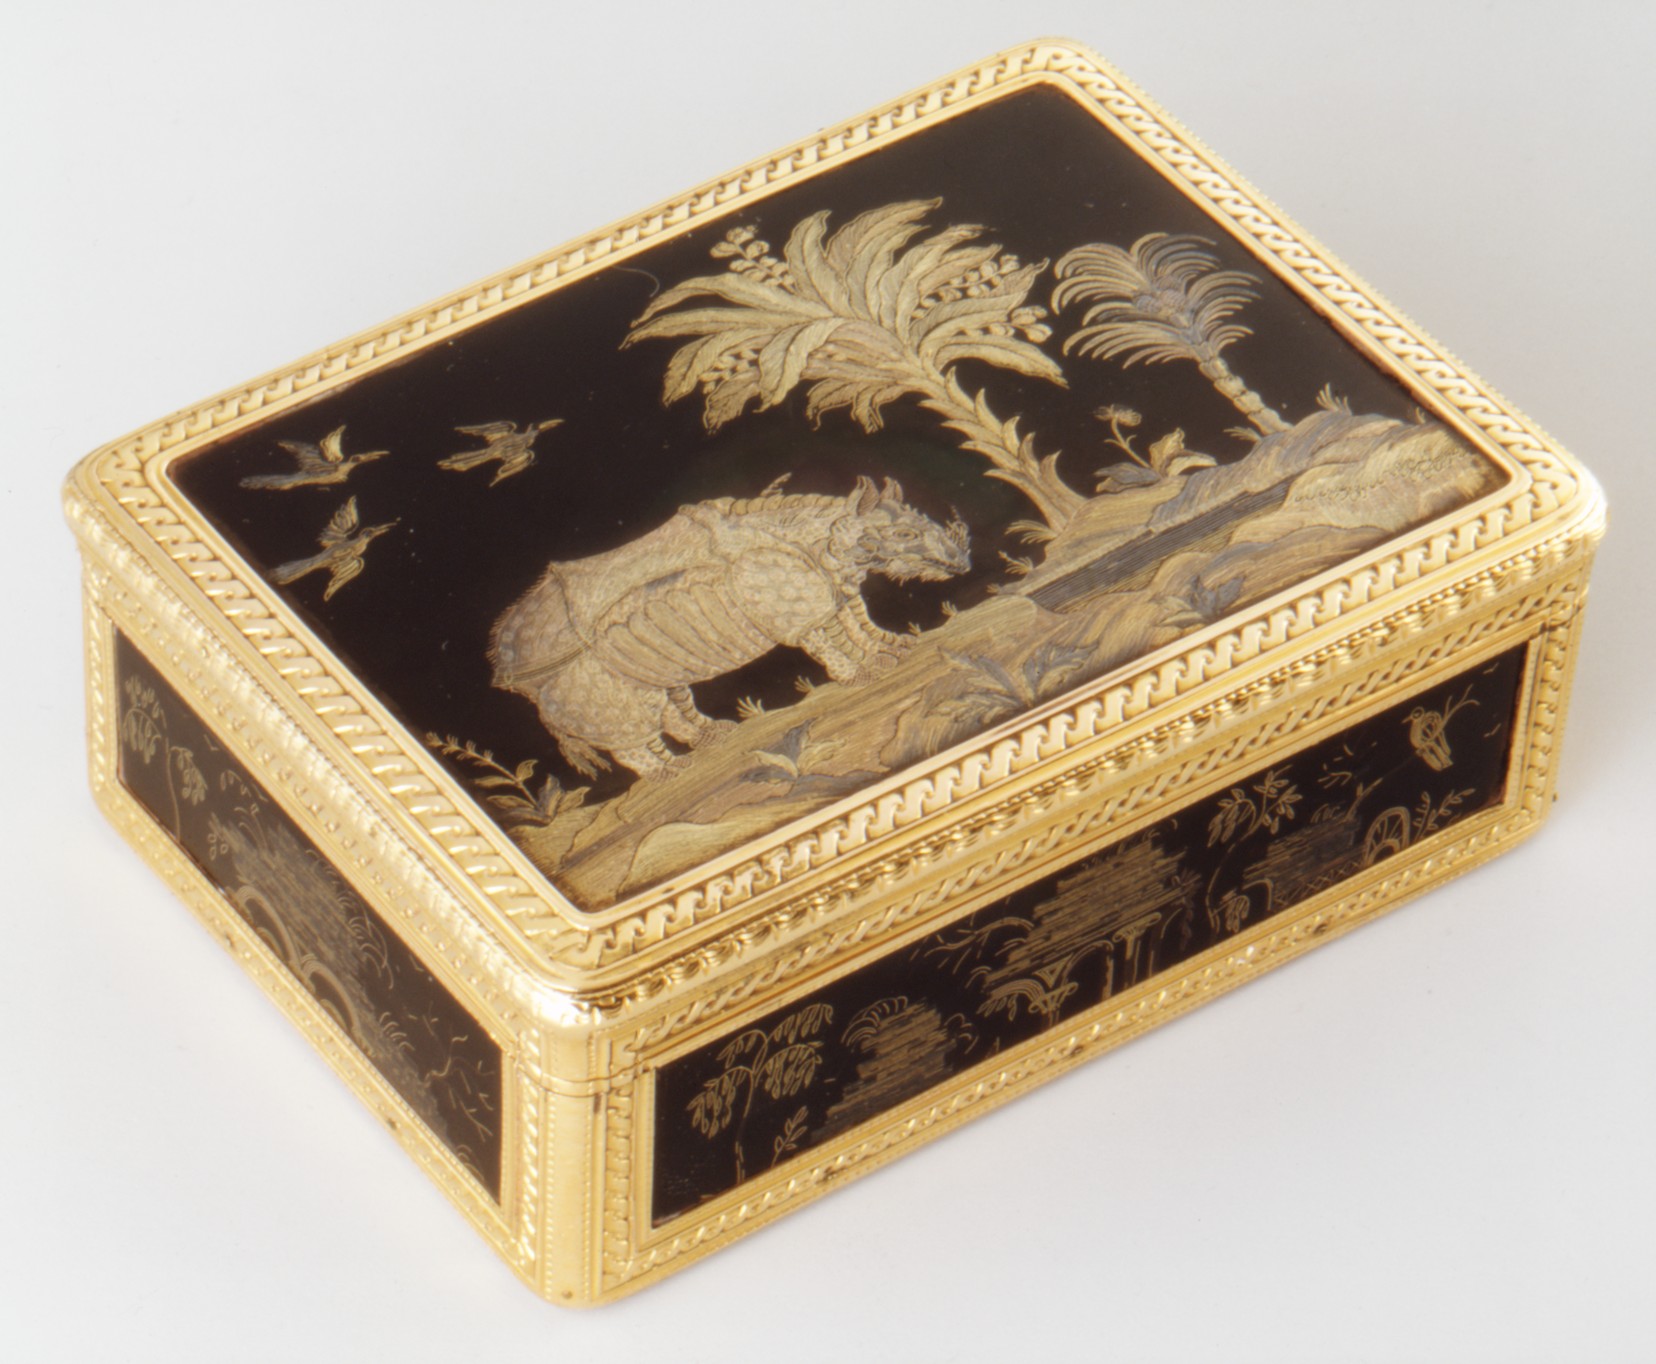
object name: snuffbox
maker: louis roucel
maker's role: maker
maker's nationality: french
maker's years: 1751-1787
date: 1768-1769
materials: gold, shell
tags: animals,birds,trees